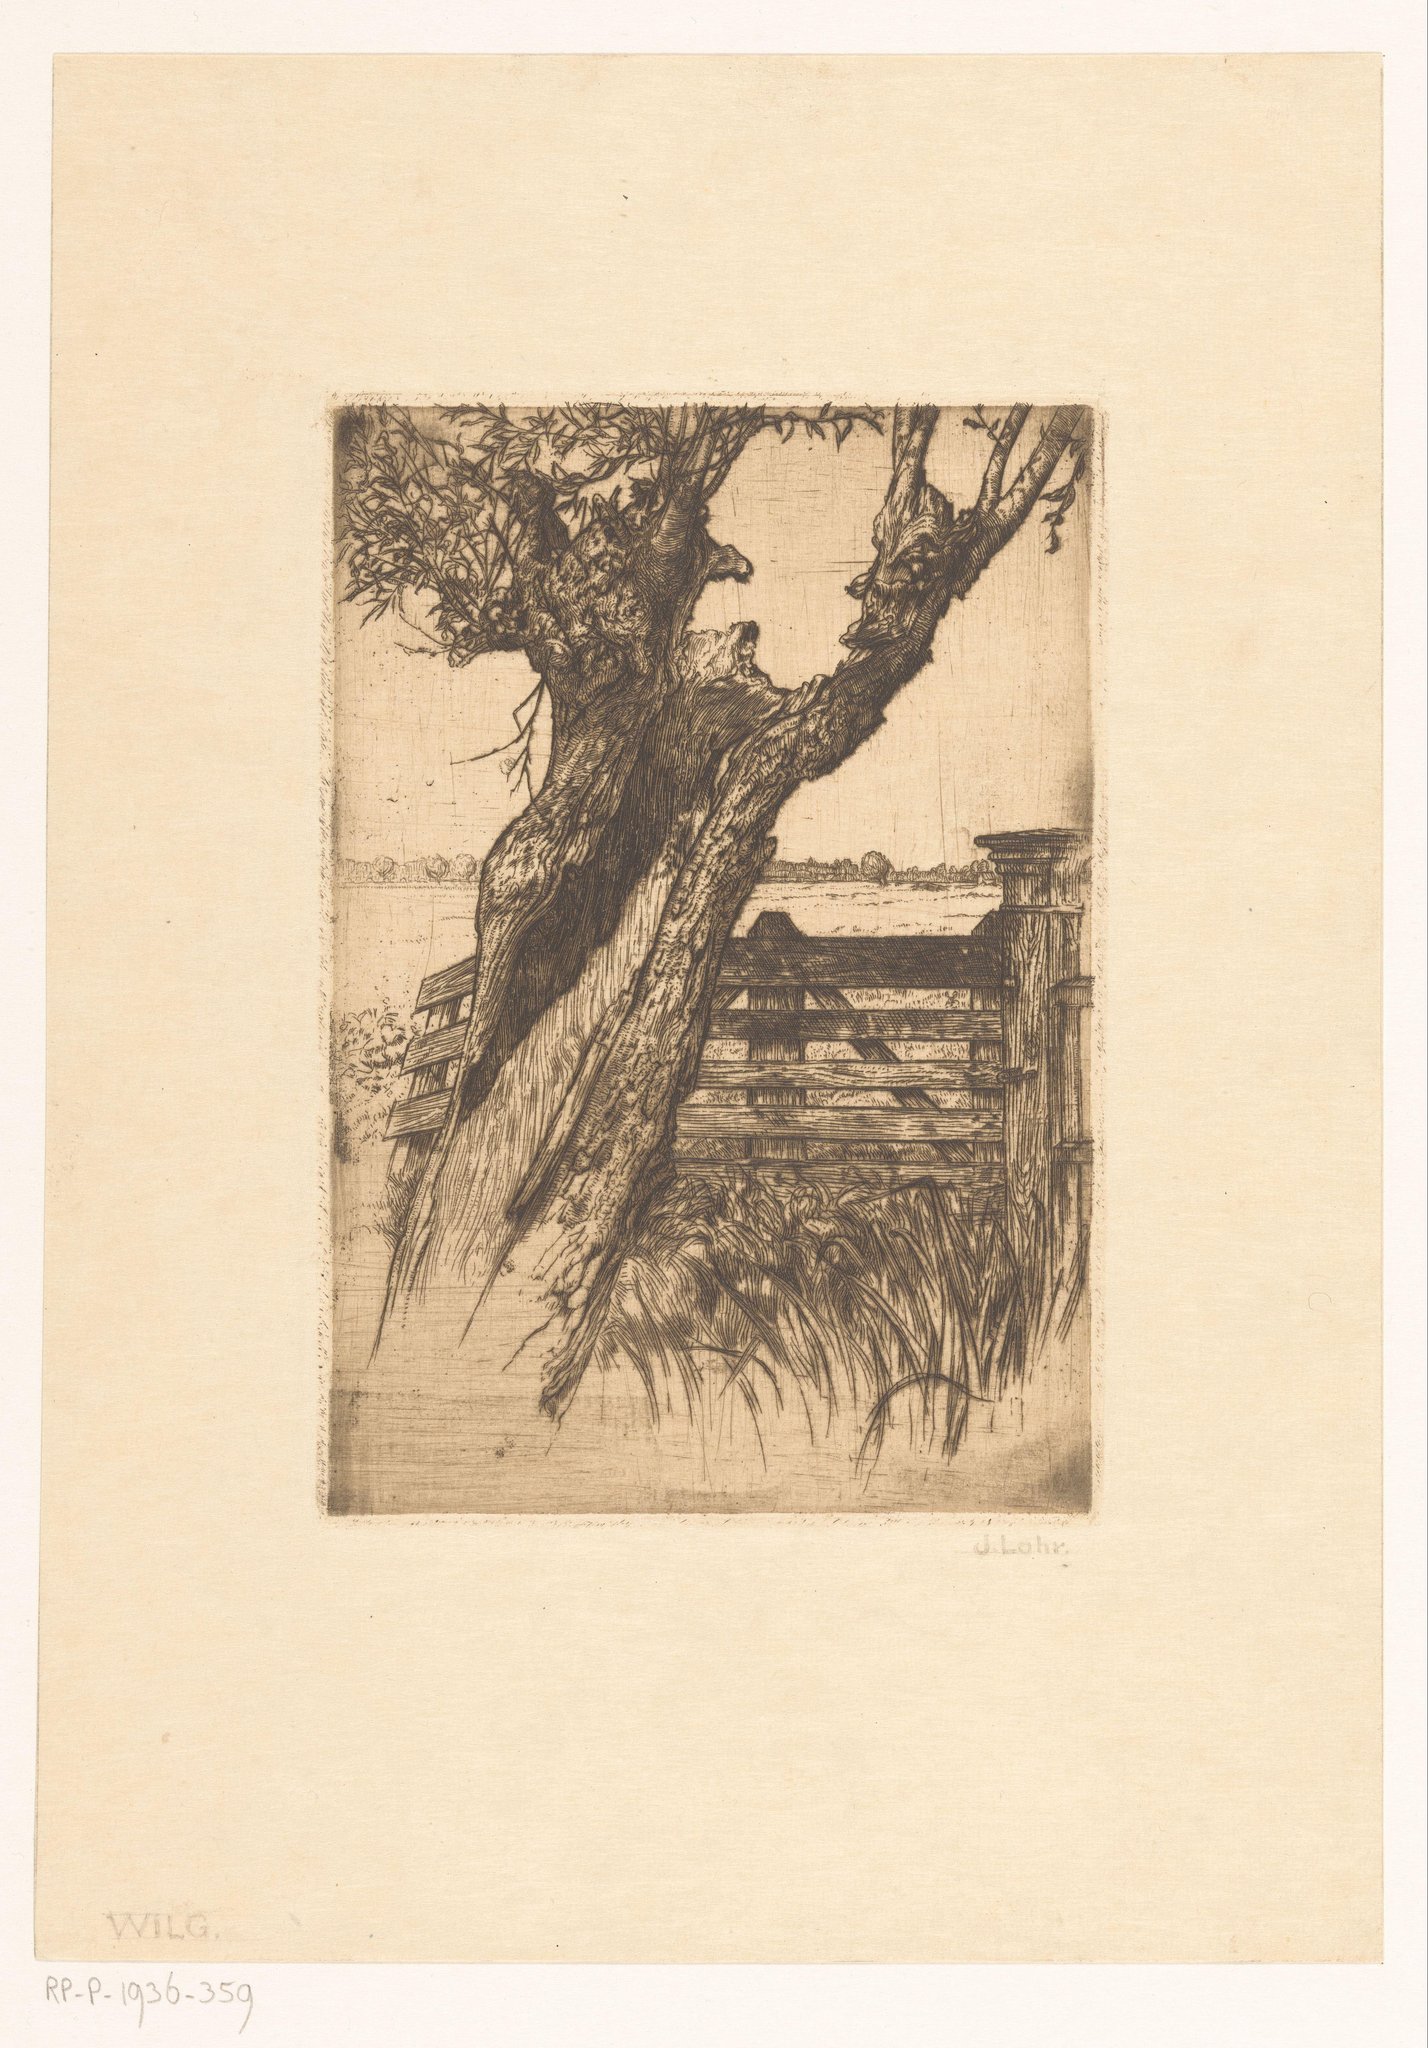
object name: print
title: Wilg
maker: johannes löhr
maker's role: print maker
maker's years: 1882-1928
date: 1892-1928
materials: paper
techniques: etching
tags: trees: willow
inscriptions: collector's mark: Lugt 2228, collector's mark: Lugt 2760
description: Wilg bij een hek in een polderlandschap.